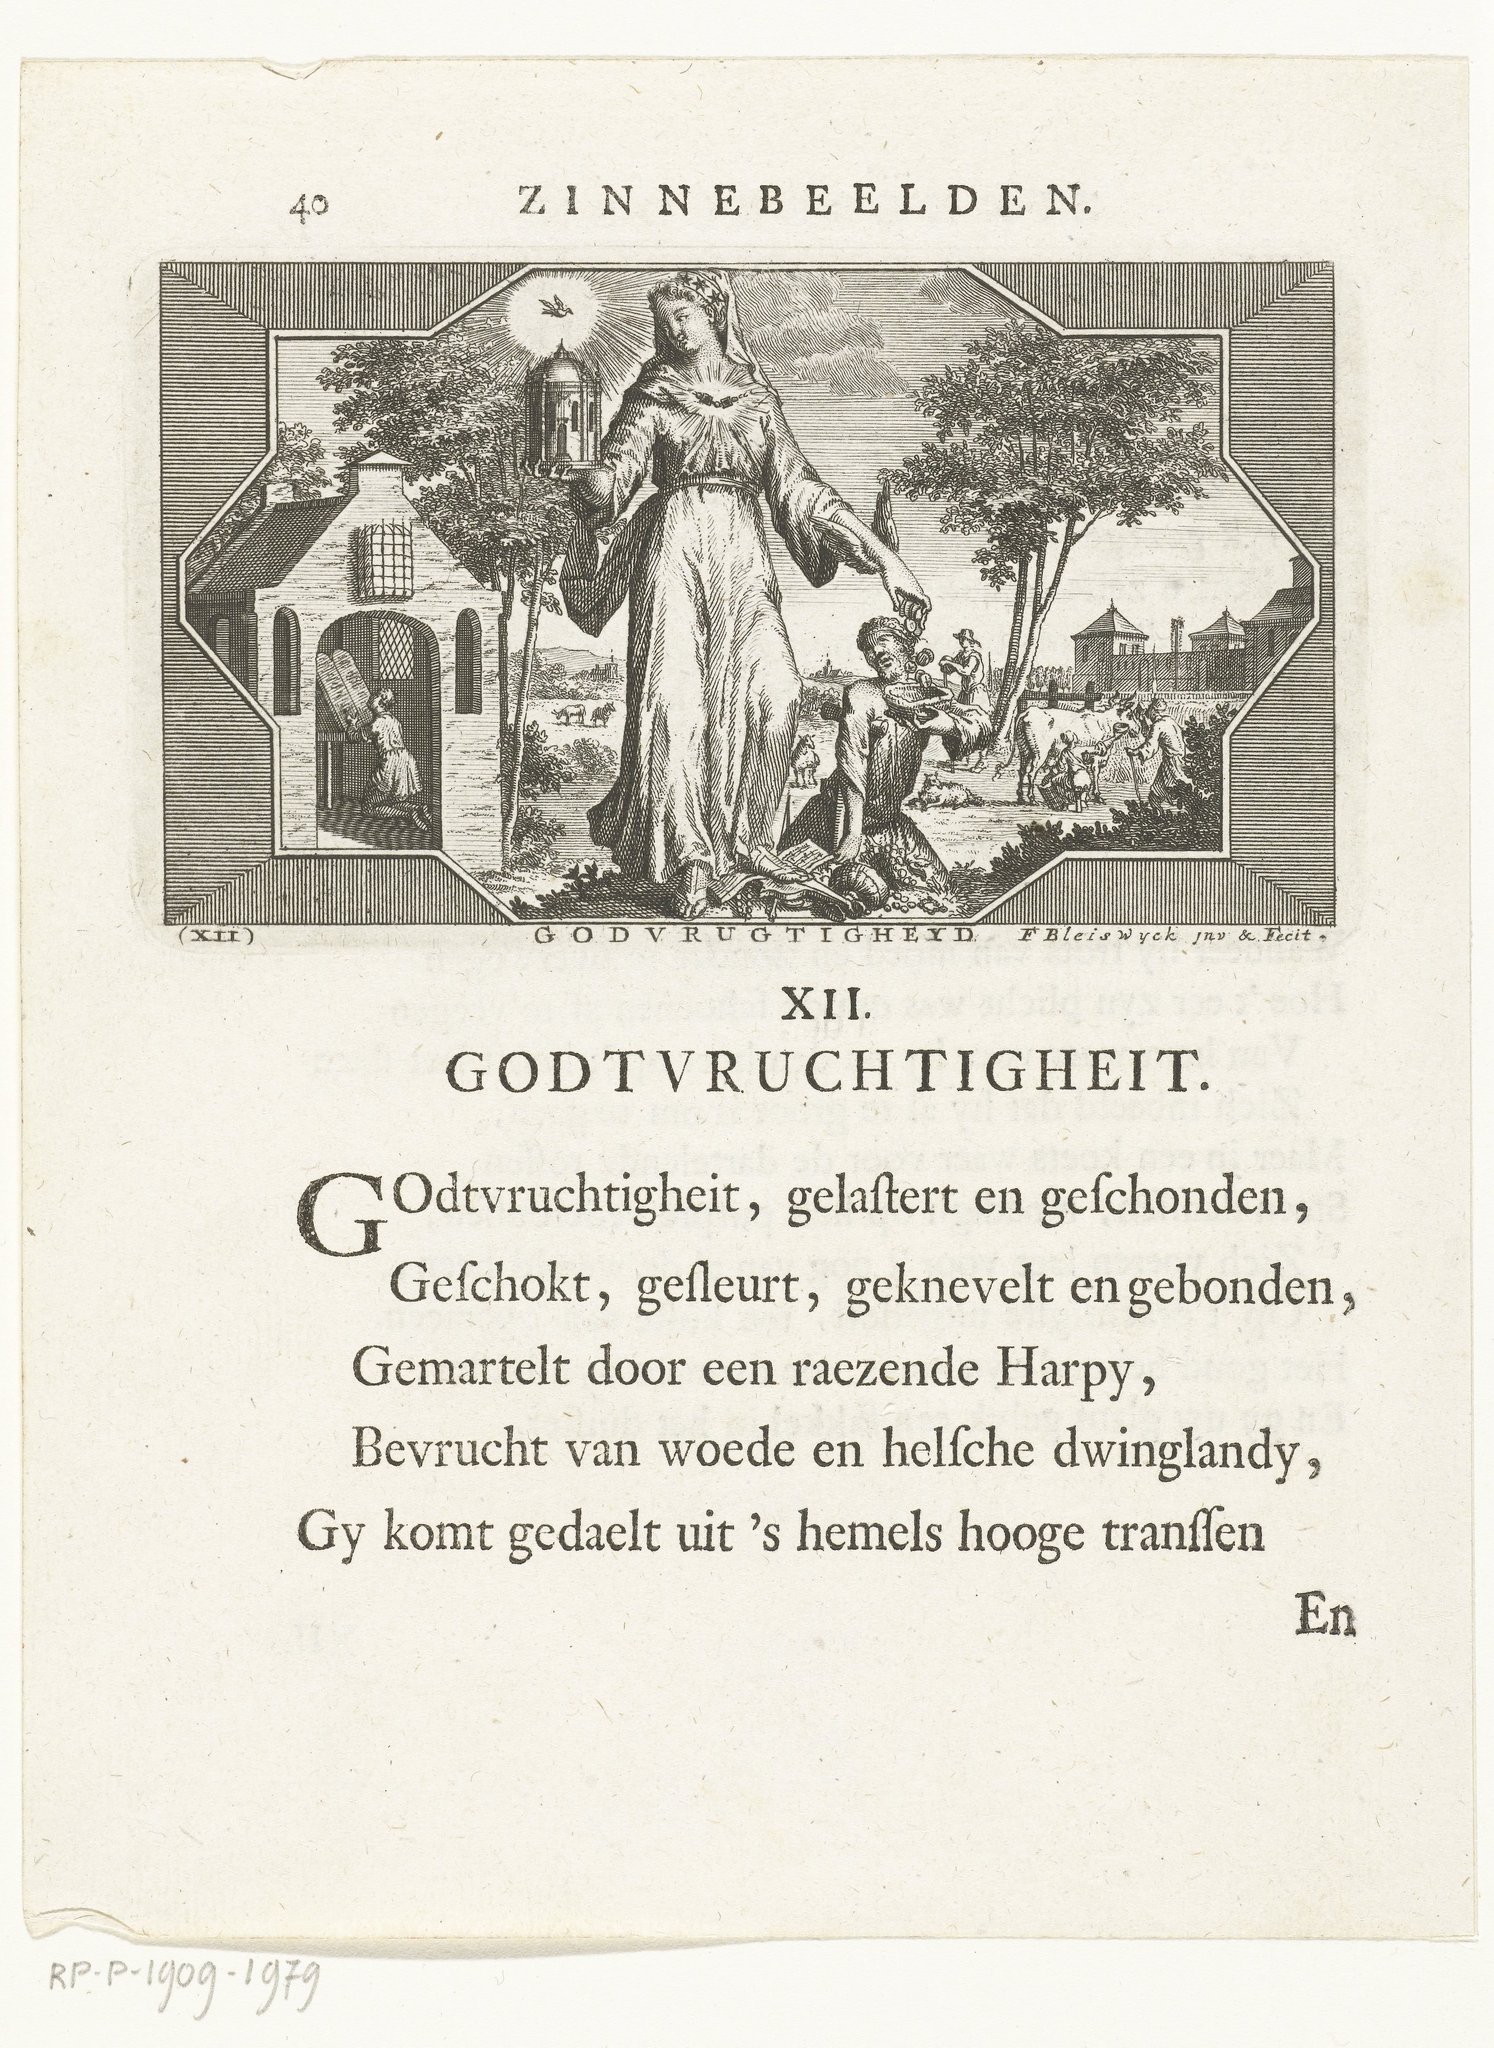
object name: print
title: Embleem met allegorie op vroomheid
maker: françois van bleyswijck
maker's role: draughtsman, print maker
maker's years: 1671-1746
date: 1681-1737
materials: paper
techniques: etching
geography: leiden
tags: devotion, piety; 'divotione' (ripa)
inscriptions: collector's mark: Lugt 2228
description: Embleem met allegorie op vroomheid (godvruchtigheid) verbeeld als vrouw met kerkmodel, zij geeft geld aan een bedelaar. In een kapel zit een man geknield voor de tafelen der wet. Onder de voorstelling en op het verso staat een gedicht.